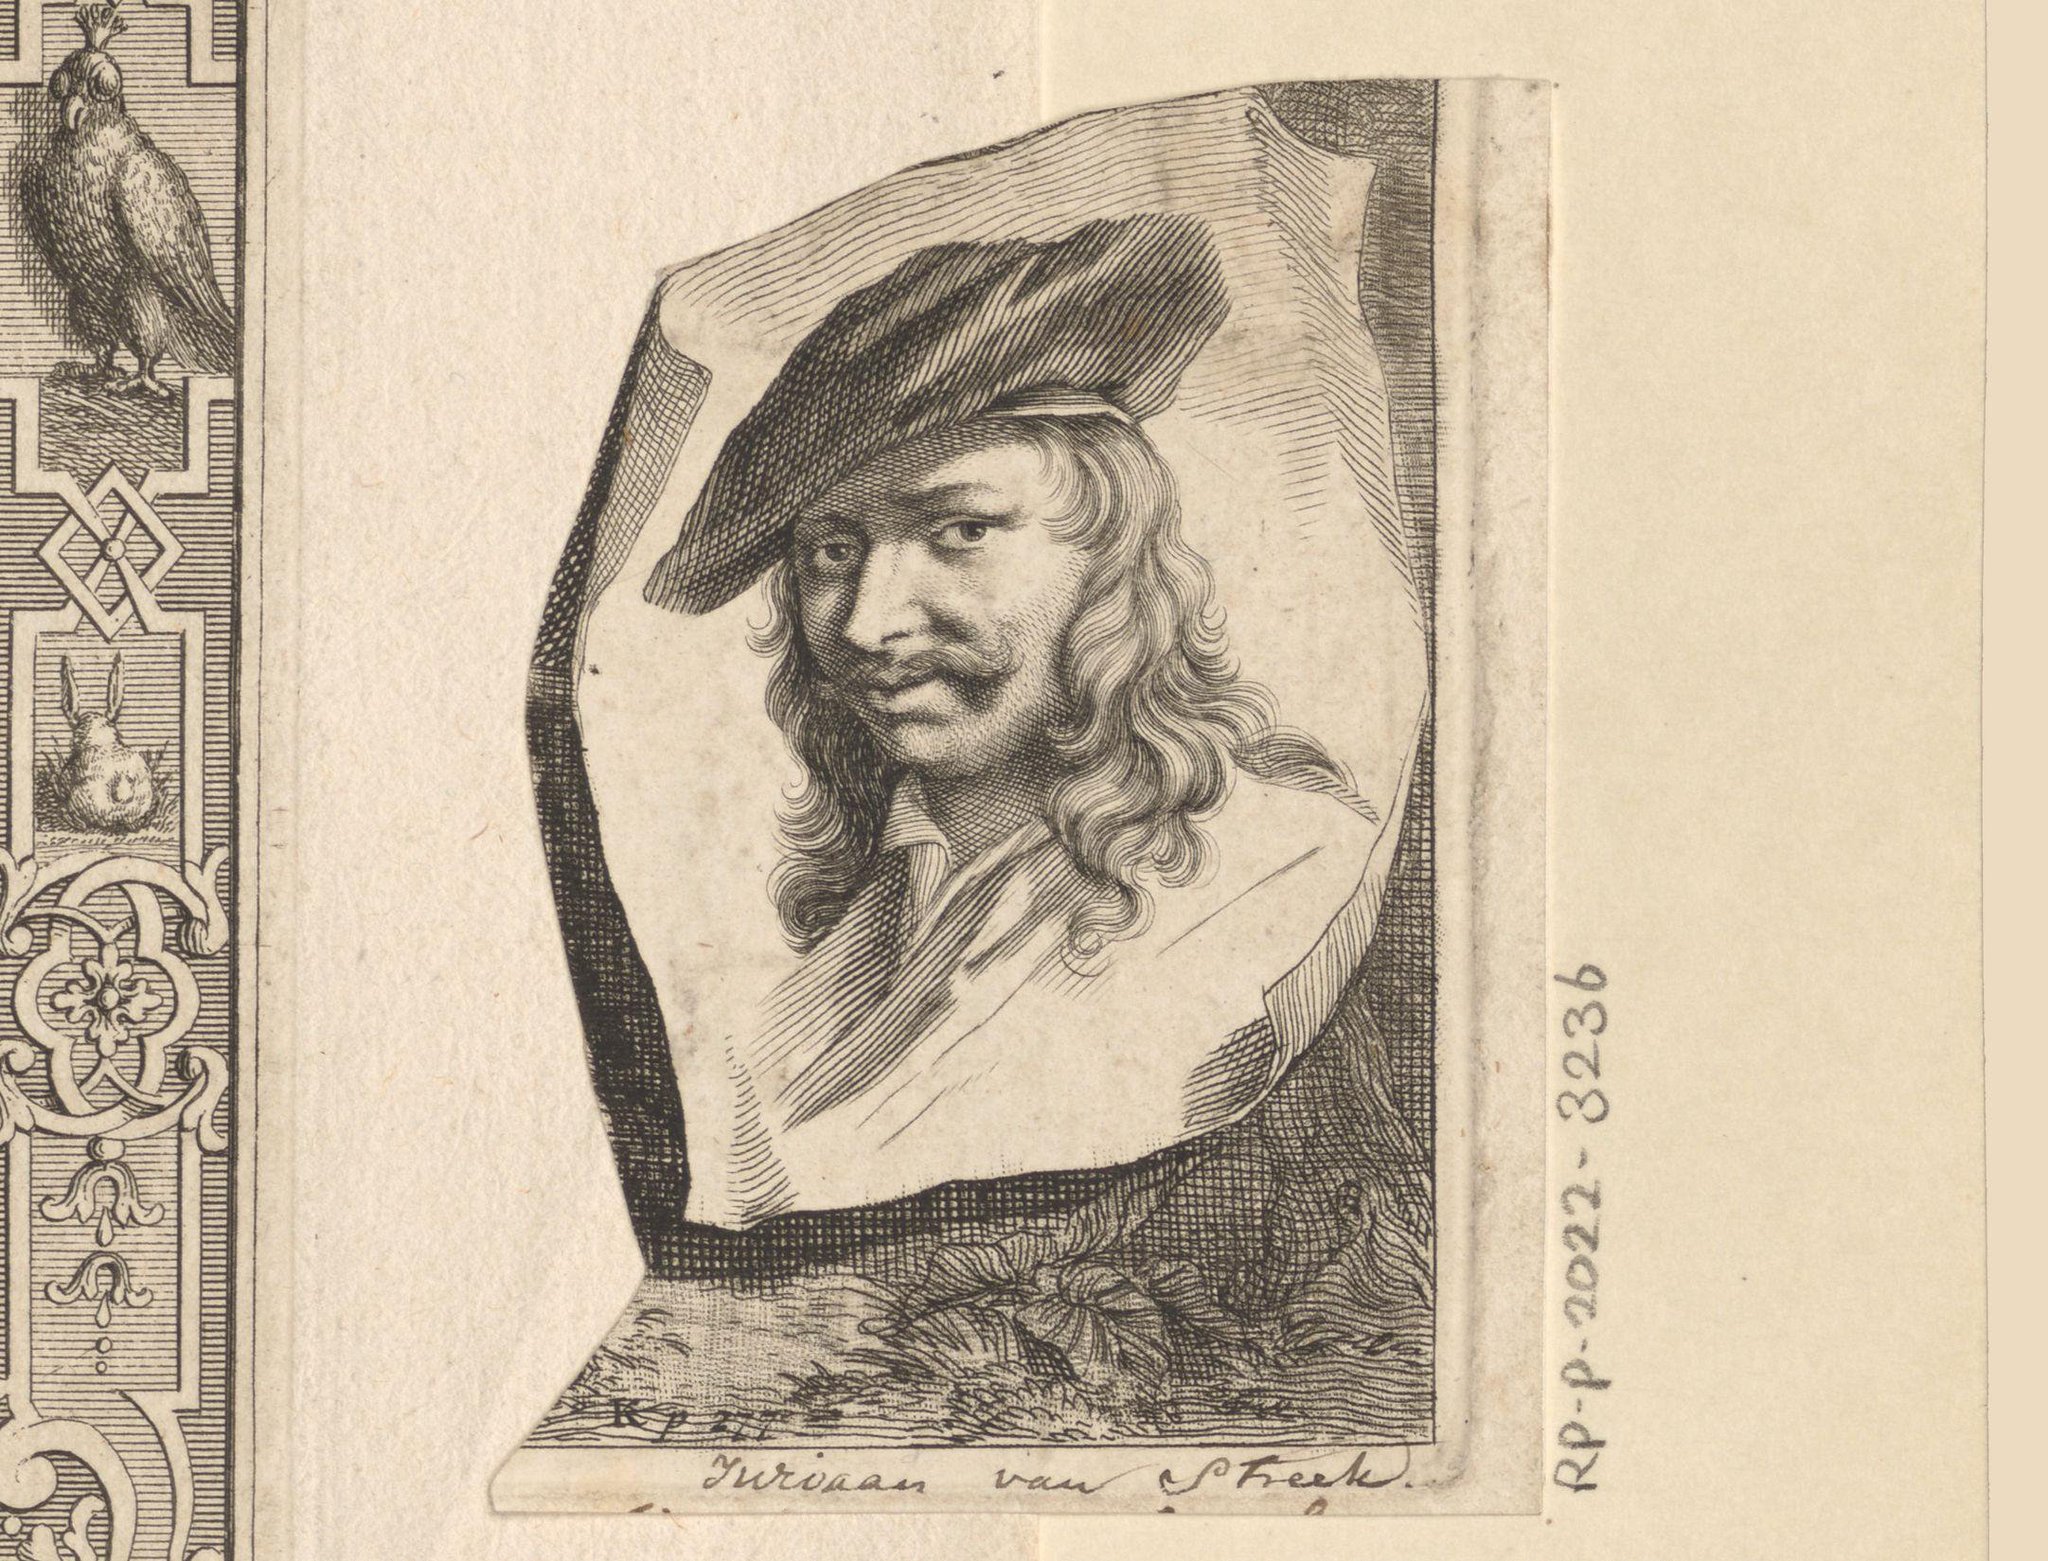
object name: print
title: Portret van Juriaan van Streek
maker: jacob houbraken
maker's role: draughtsman, print maker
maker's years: 1698-1780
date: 1729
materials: paper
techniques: engraving, etching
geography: amsterdam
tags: artist, historical persons, portrait, self-portrait of artist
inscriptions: name: ‘Juriaan van Streek’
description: Gesneden uit een grotere prent met de portretten van Johann Heinrich Roos en Juriaan van Streek.